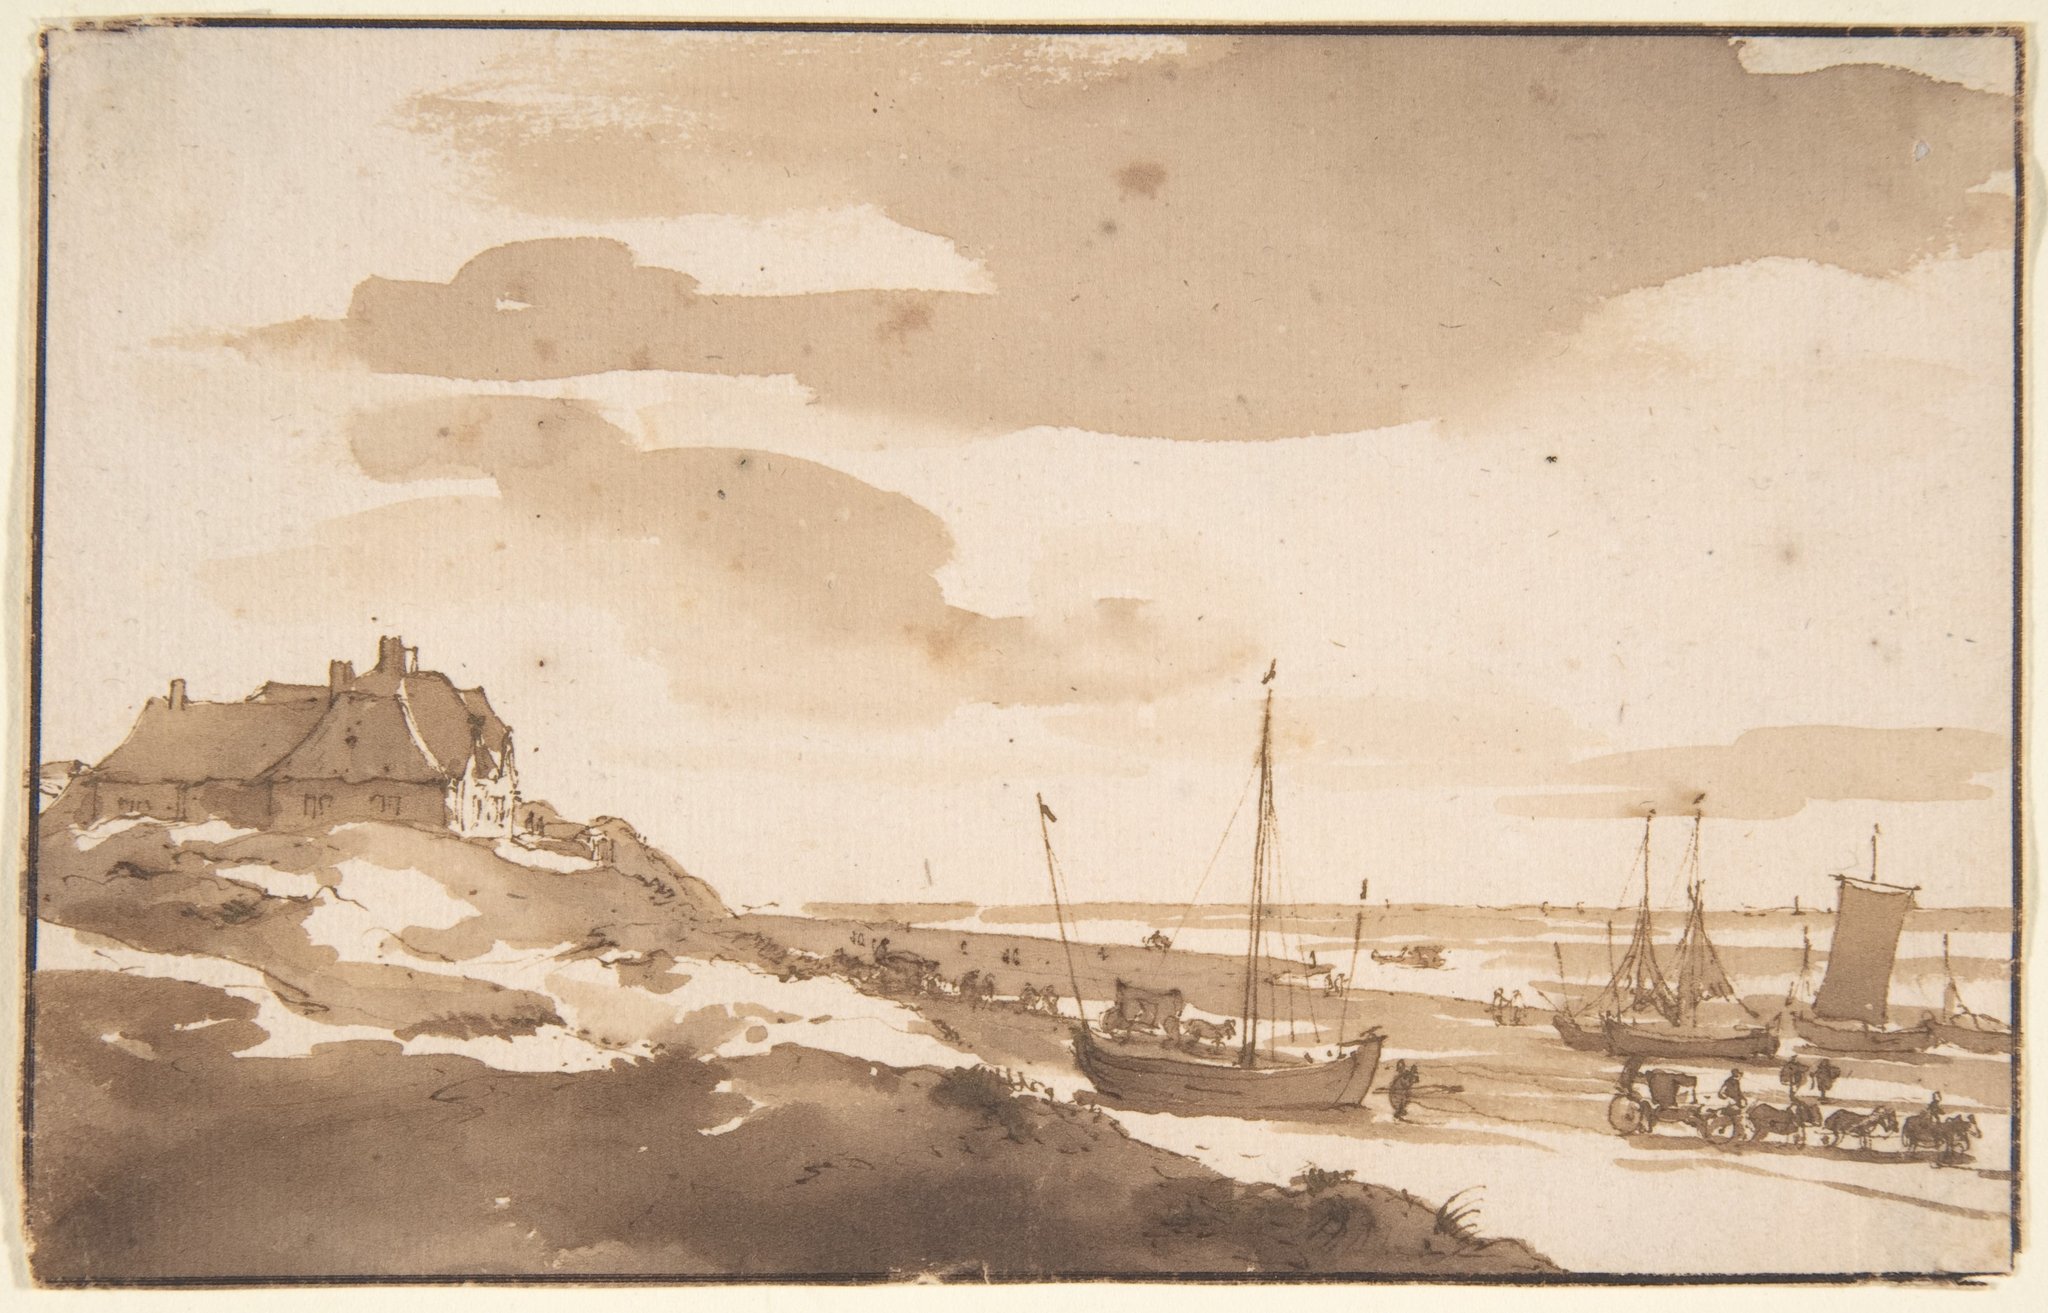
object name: drawing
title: View of the Dunes at Scheveningen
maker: jan de bisschop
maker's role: artist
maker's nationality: dutch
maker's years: 1628-1671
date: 1634-1666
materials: ink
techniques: brush, pen, wash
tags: landscapes,boats